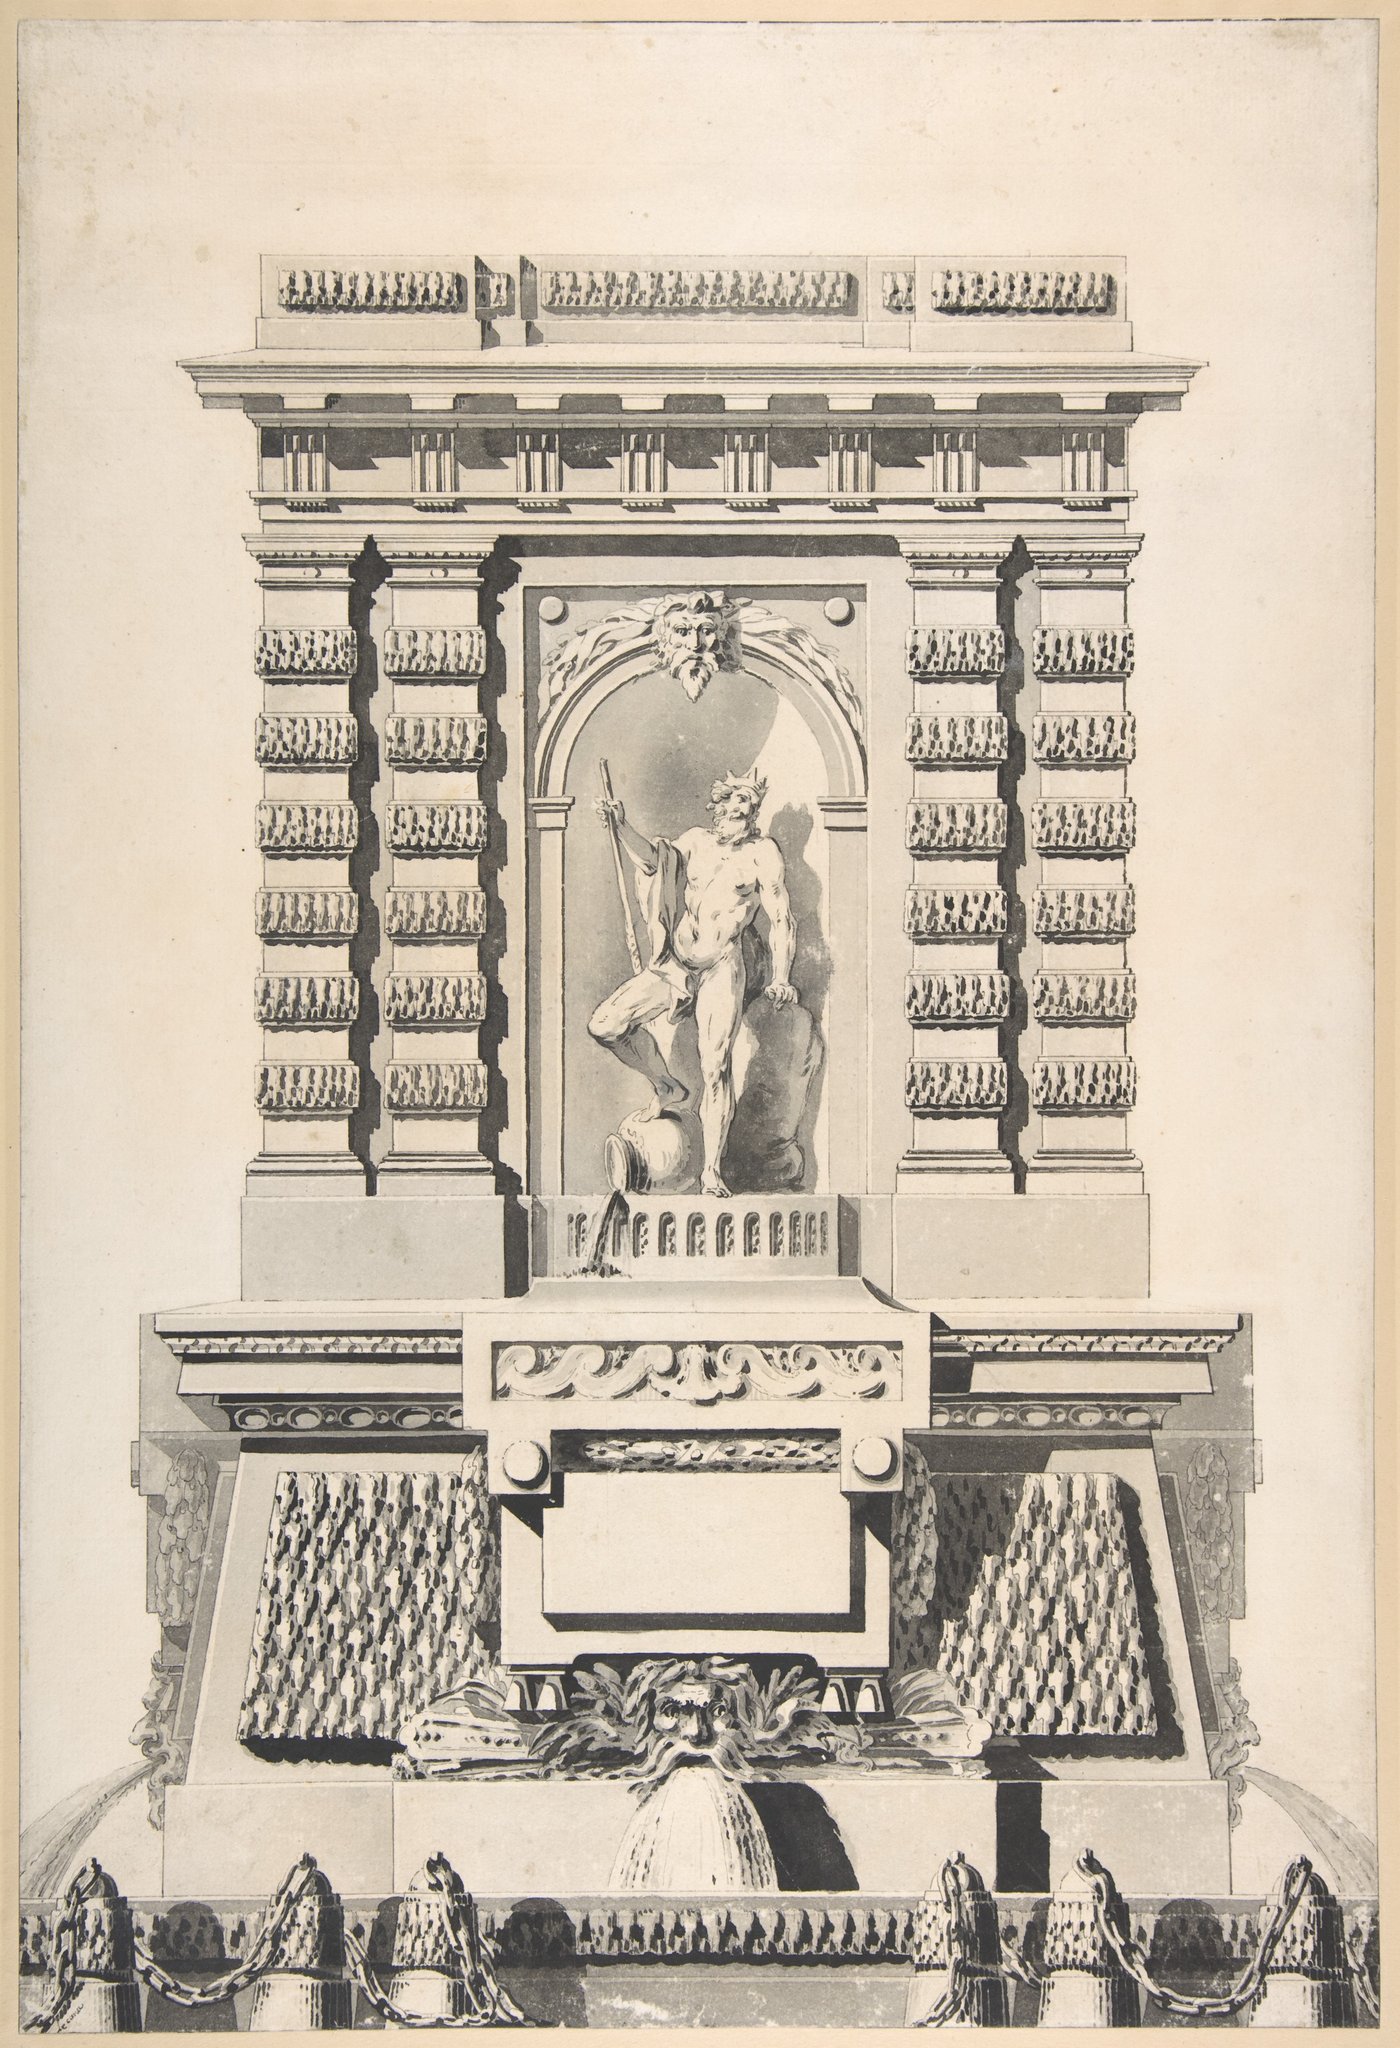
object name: drawing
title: Design for a Monumental Fountain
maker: a. le canu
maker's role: artist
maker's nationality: french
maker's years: 1750-1770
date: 1750-1770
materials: ink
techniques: brush, pen, wash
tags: fountains,monuments,male nudes